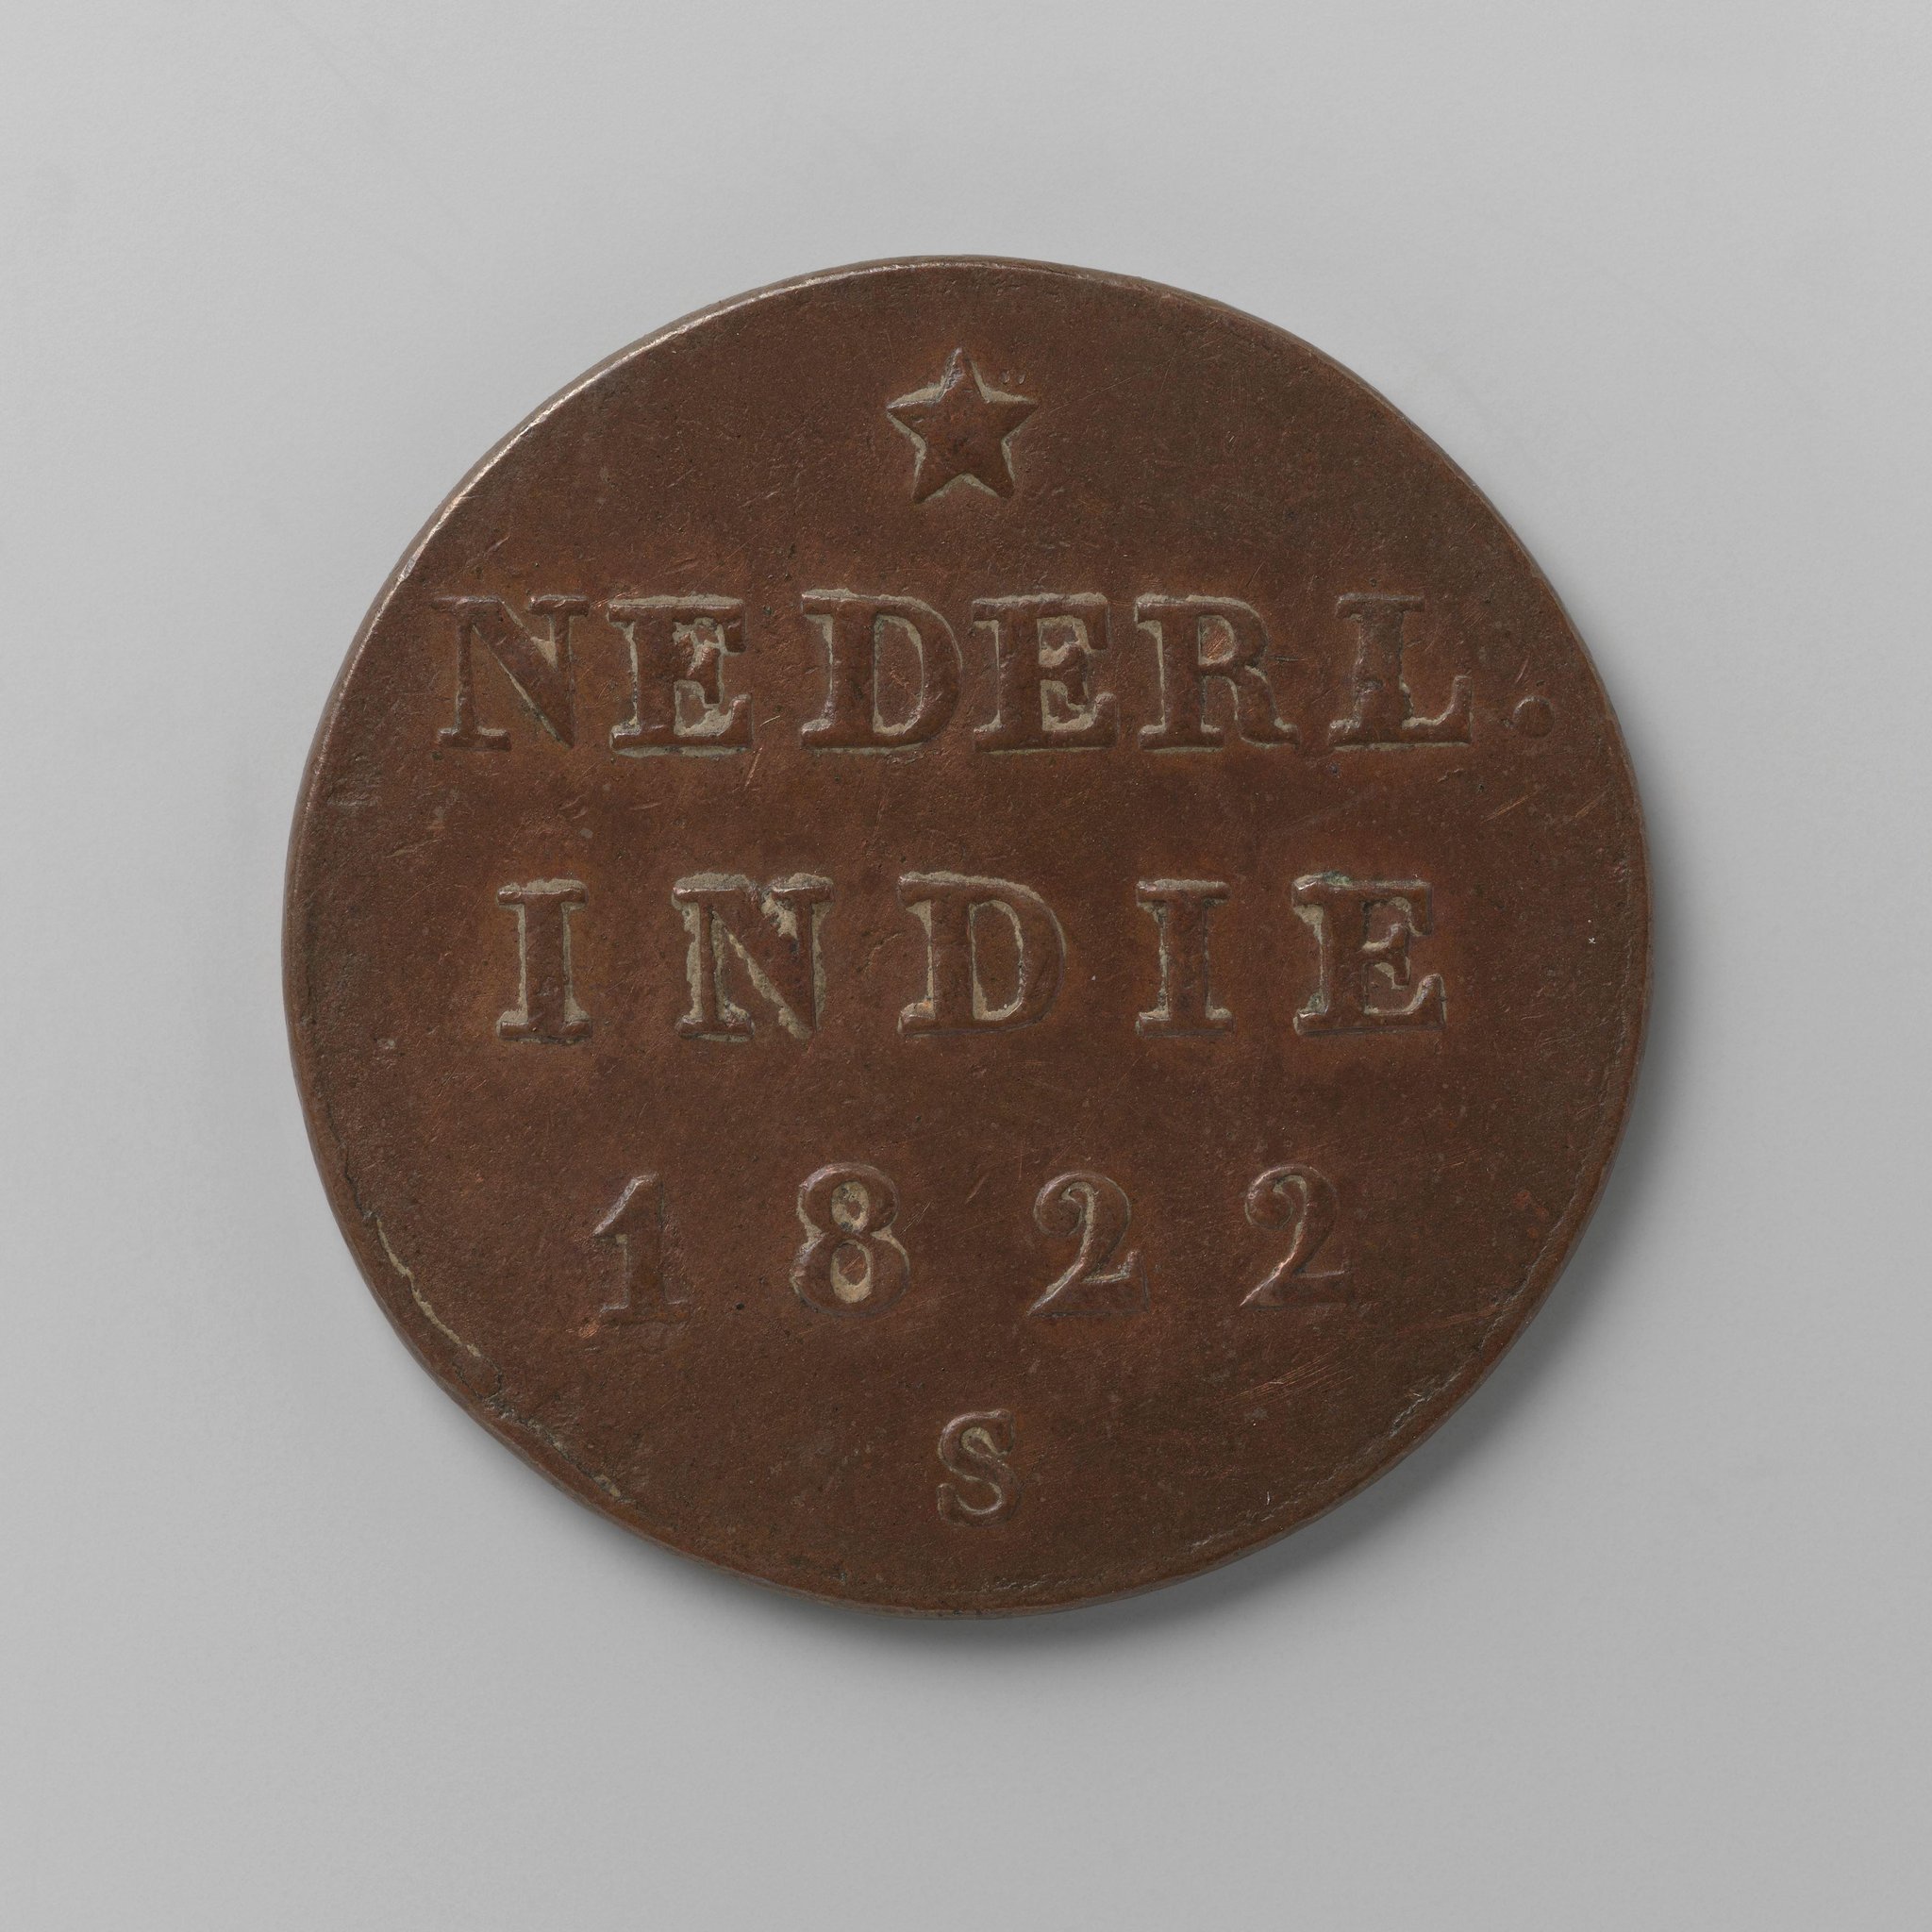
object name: coin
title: Nederlands Indië, ½ stuiver, 1822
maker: william i of the netherlands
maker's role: koning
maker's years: 1772-1843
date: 1822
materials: copper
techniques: striking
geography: utrecht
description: Koperen munt. Voorzijde: tussen waarde-aanduiding ½ St. gekroond rijkswapenschild. Keerzijde: tweeregelig opschrift, waarboven muntteken en waaronder jaartal. Daaronder muntmeesterteken S [=Suermondt]. Gladde rand.